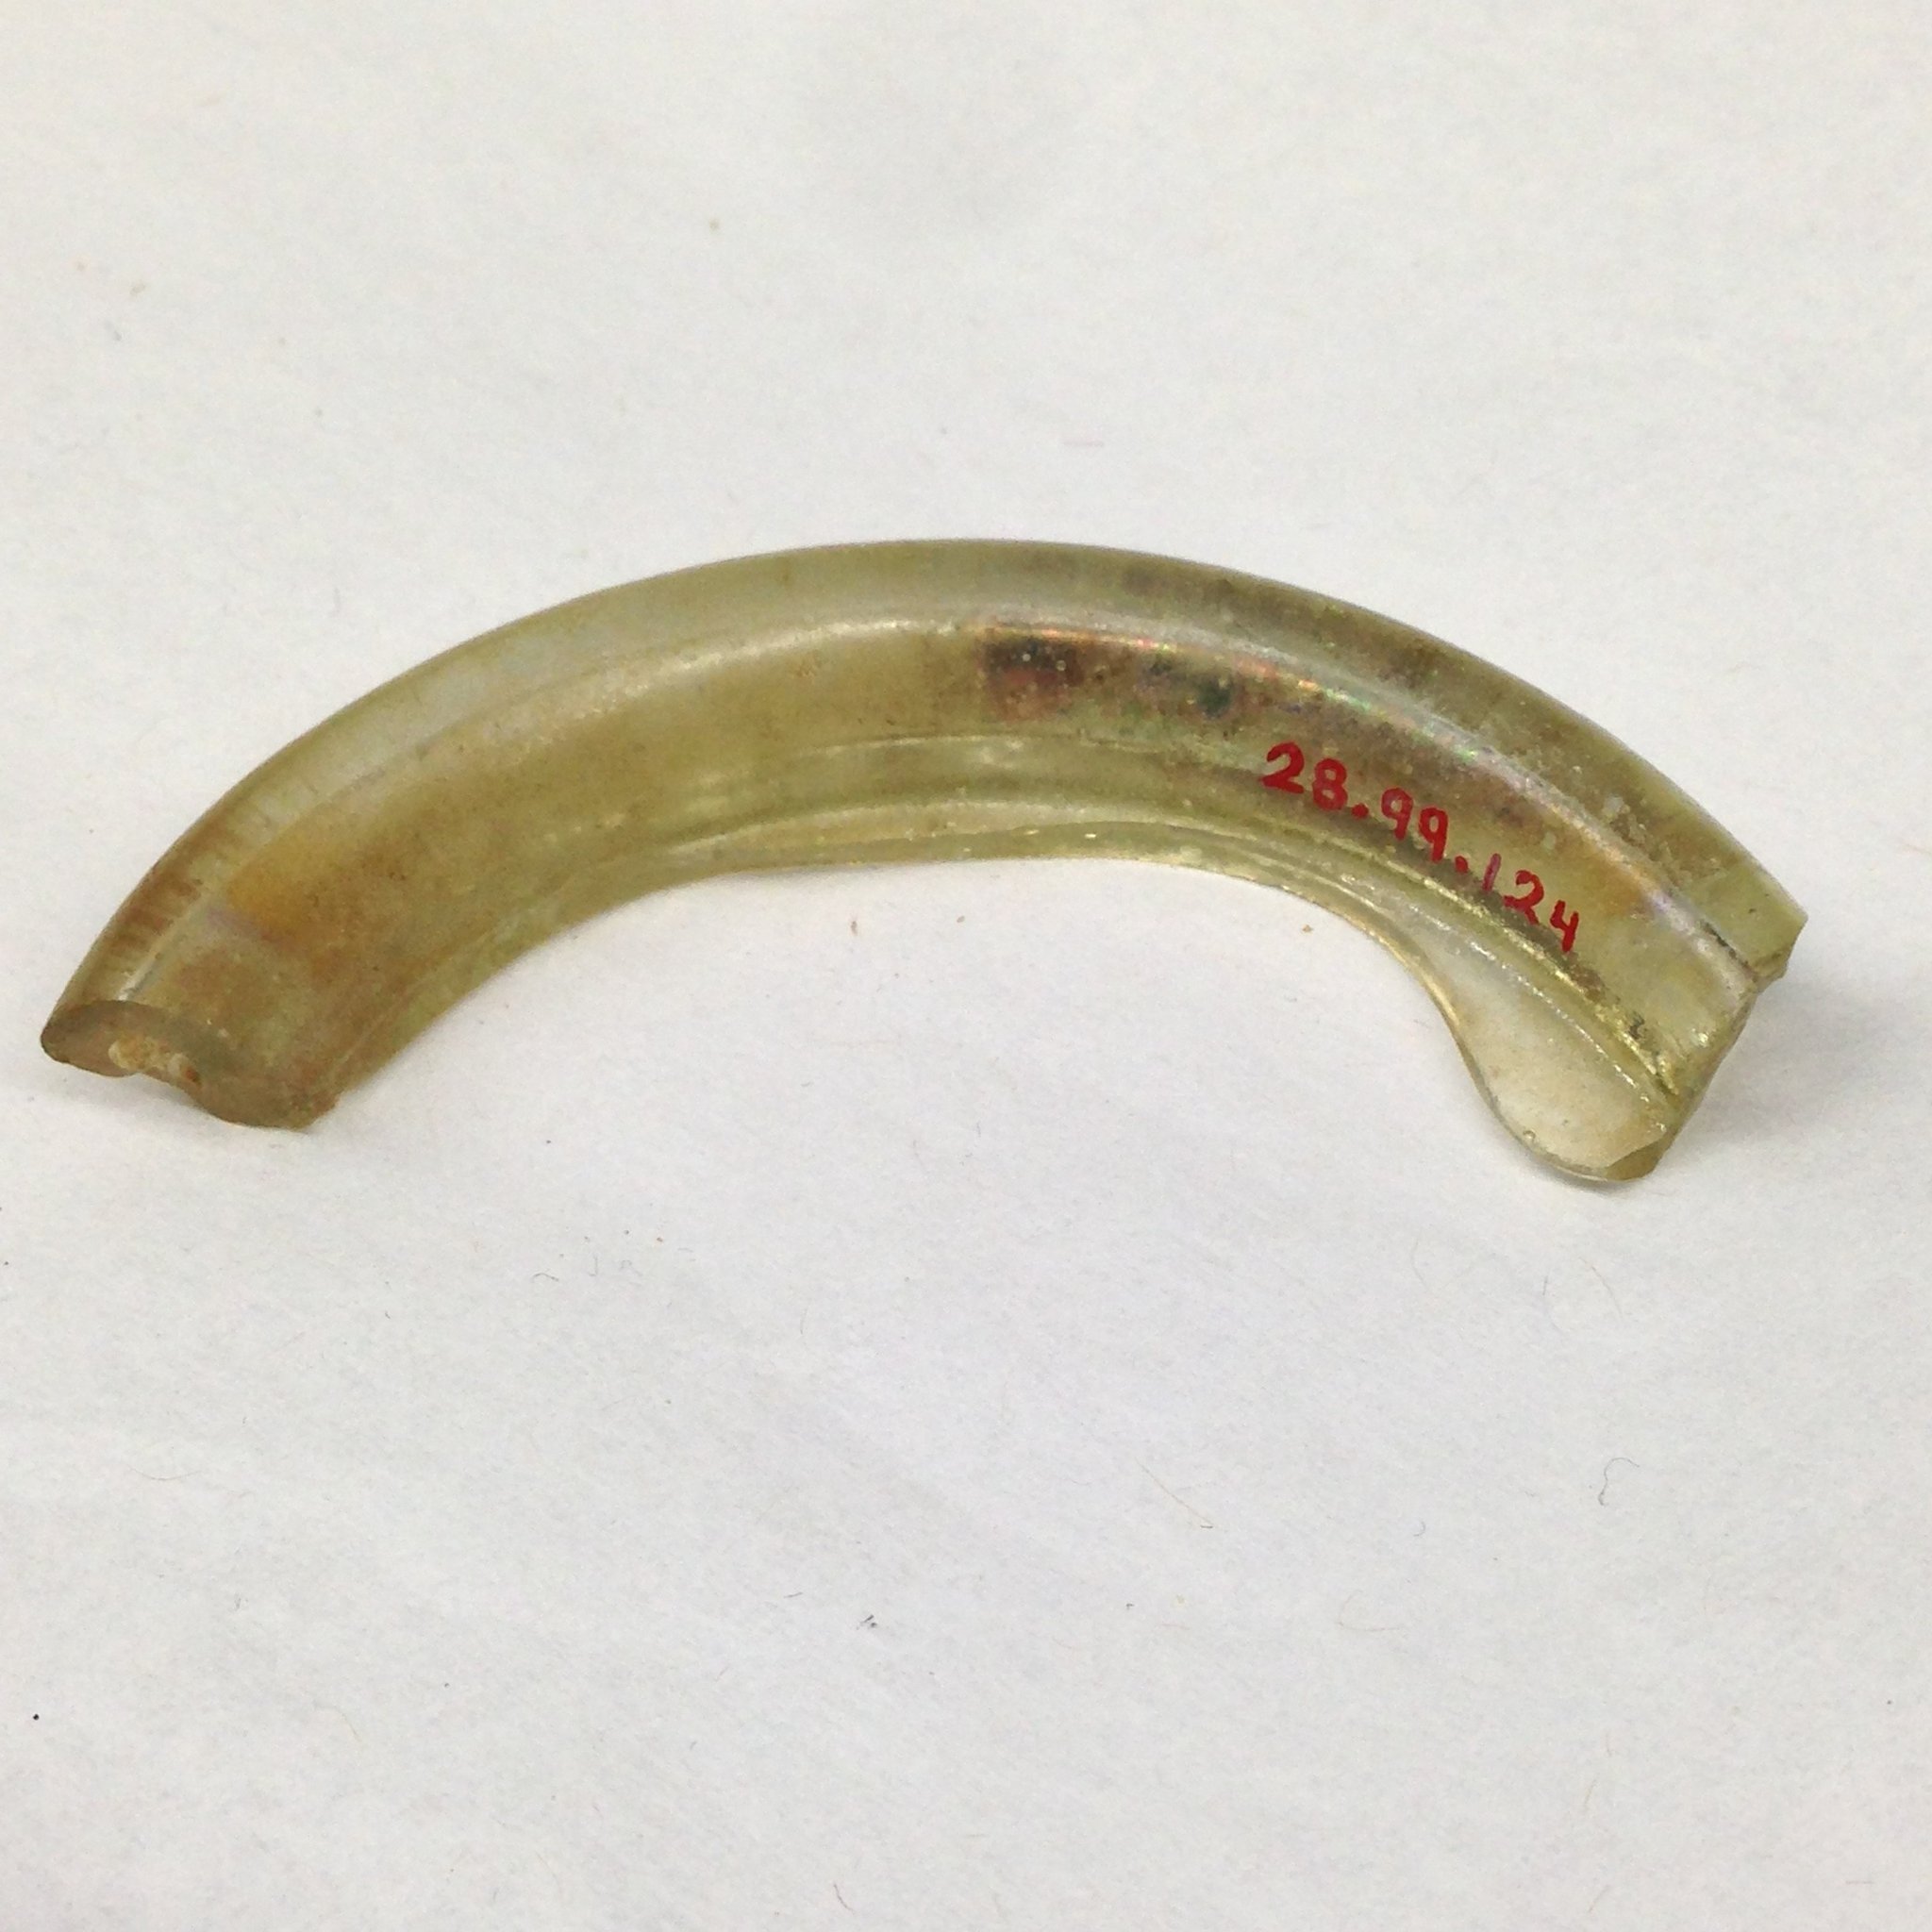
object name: fragment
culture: european or middle eastern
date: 1150-1250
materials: ceramic, glass